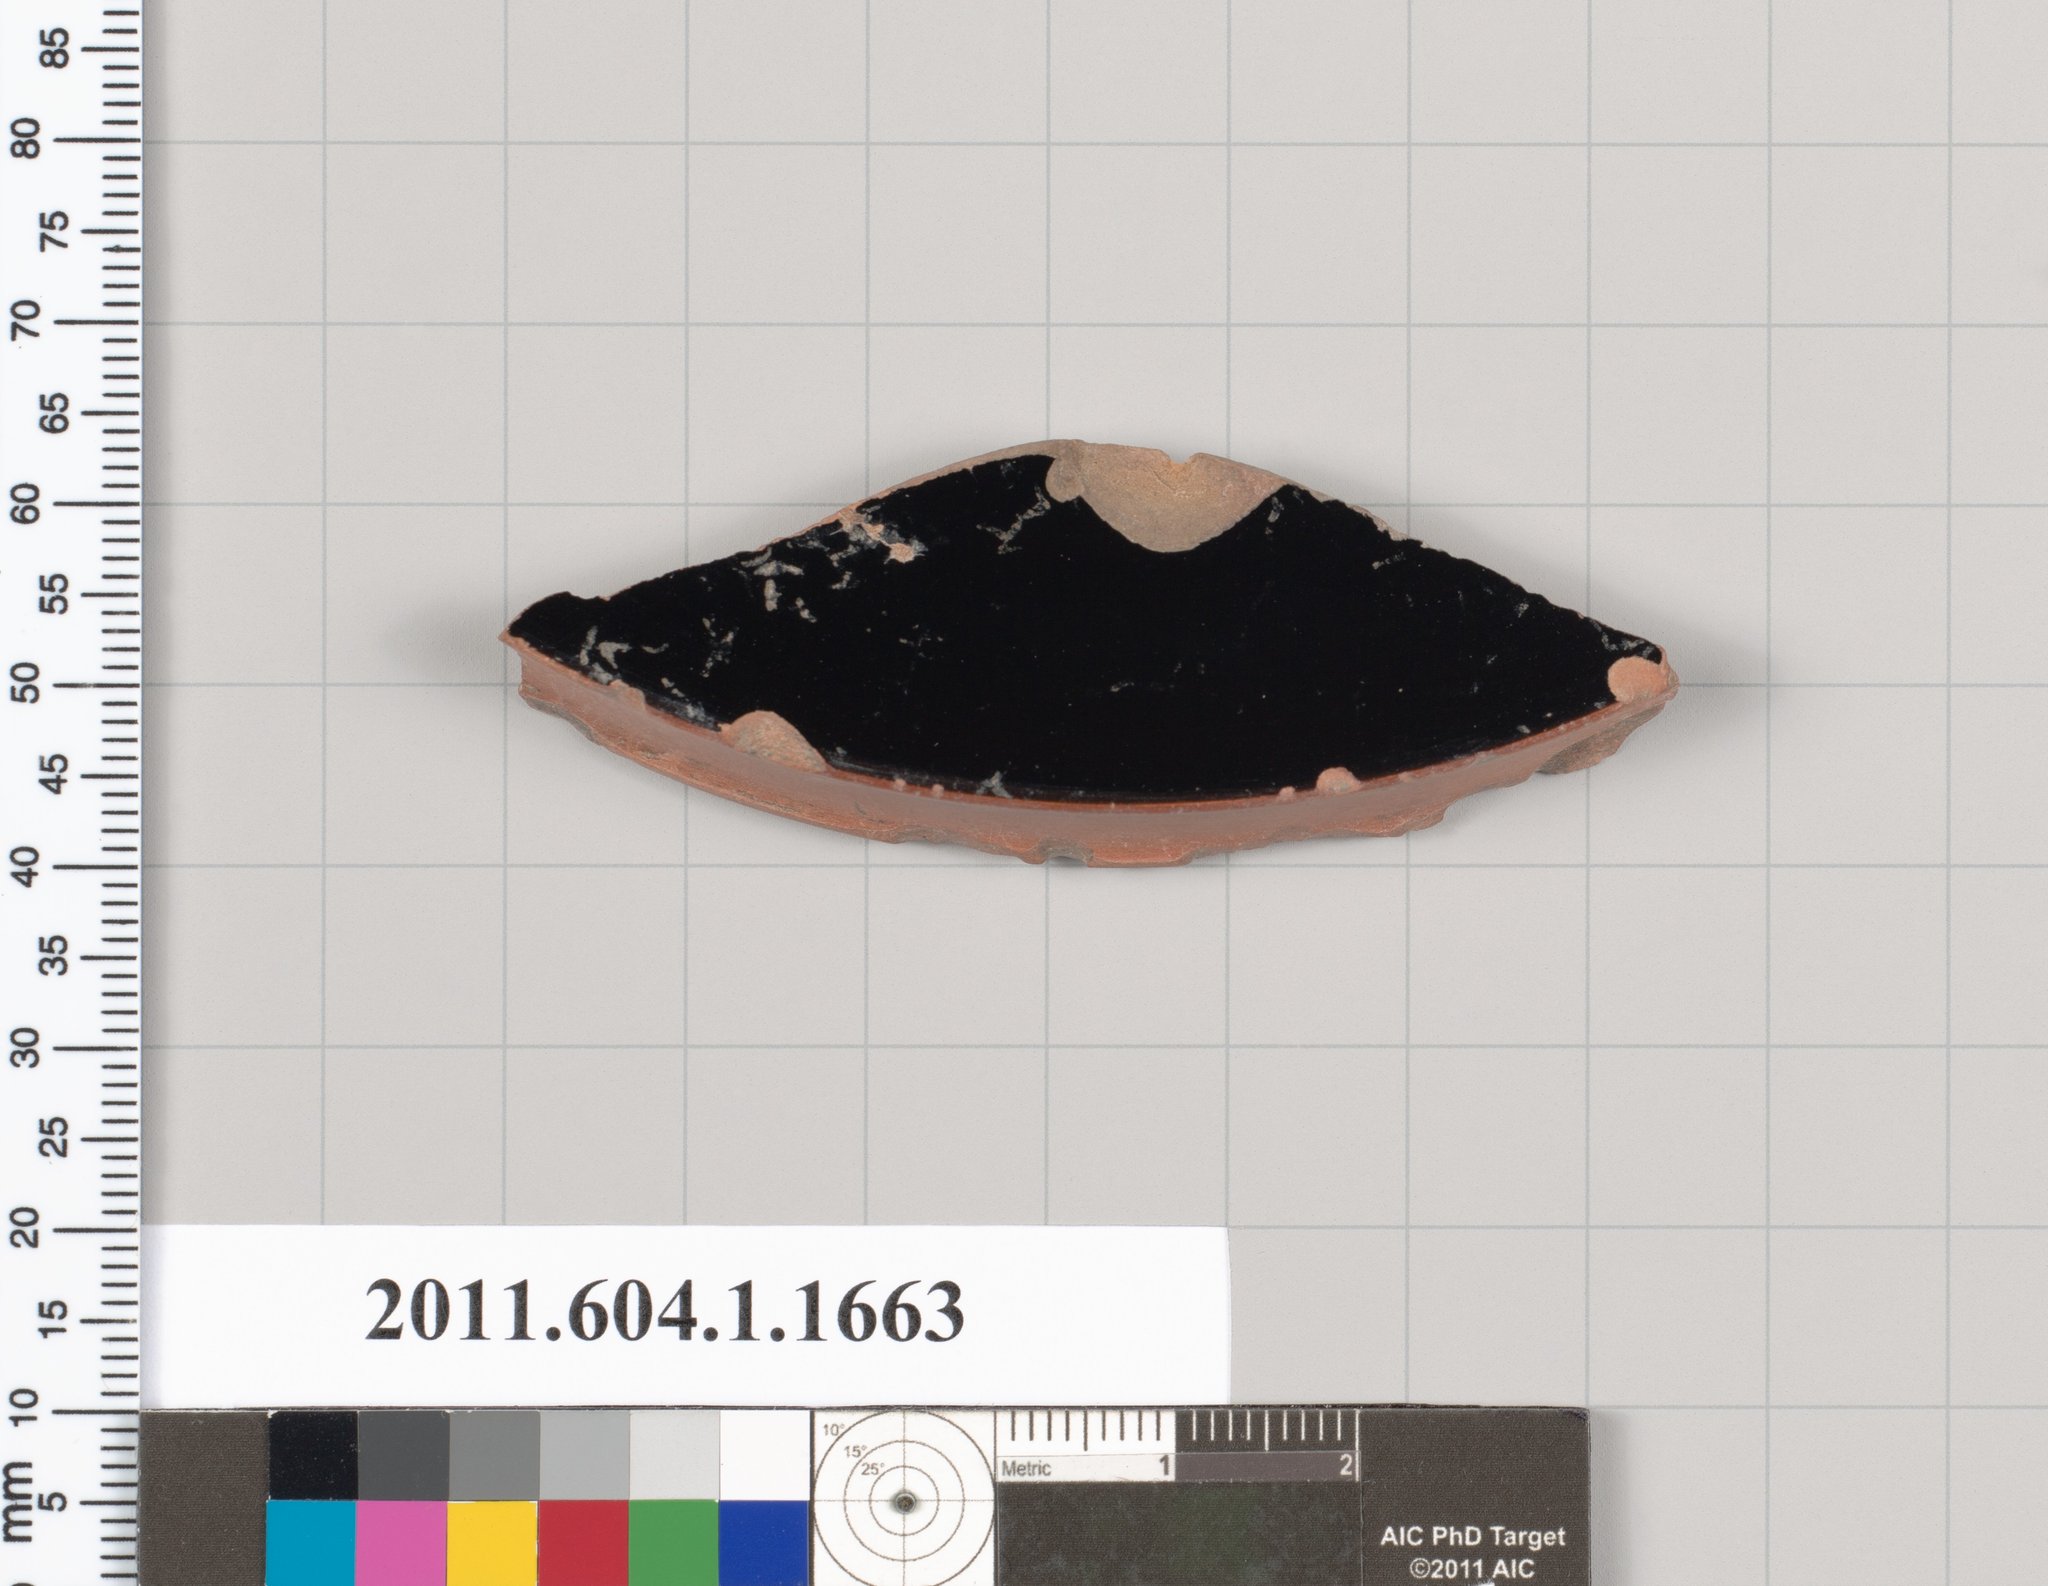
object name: kylix fragment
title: Terracotta fragment of a kylix (drinking cup)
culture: greek, attic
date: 530-510 BCE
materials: terracotta